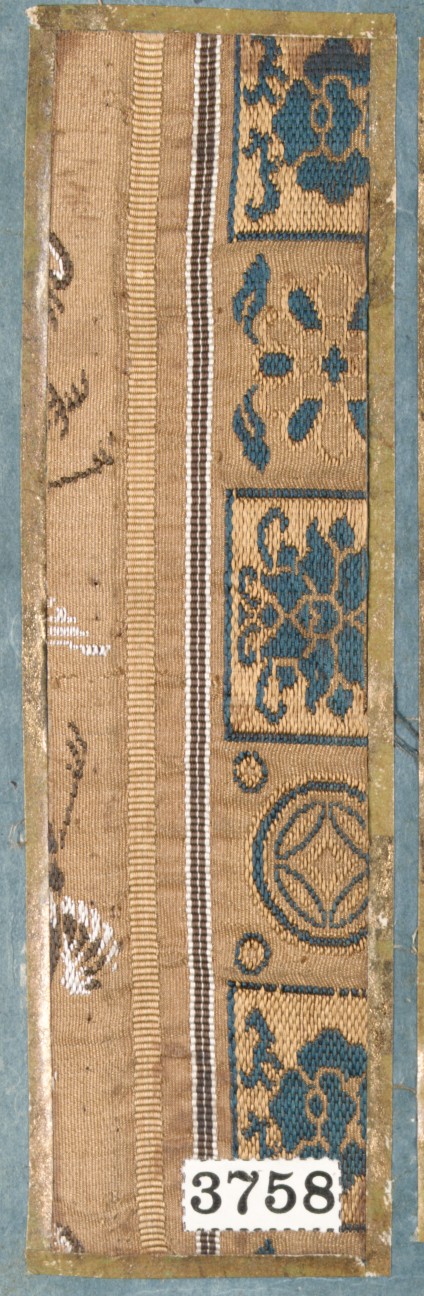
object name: sample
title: Textile Sample from Sample Book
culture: japanese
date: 1801-1900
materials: silk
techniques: tapestry